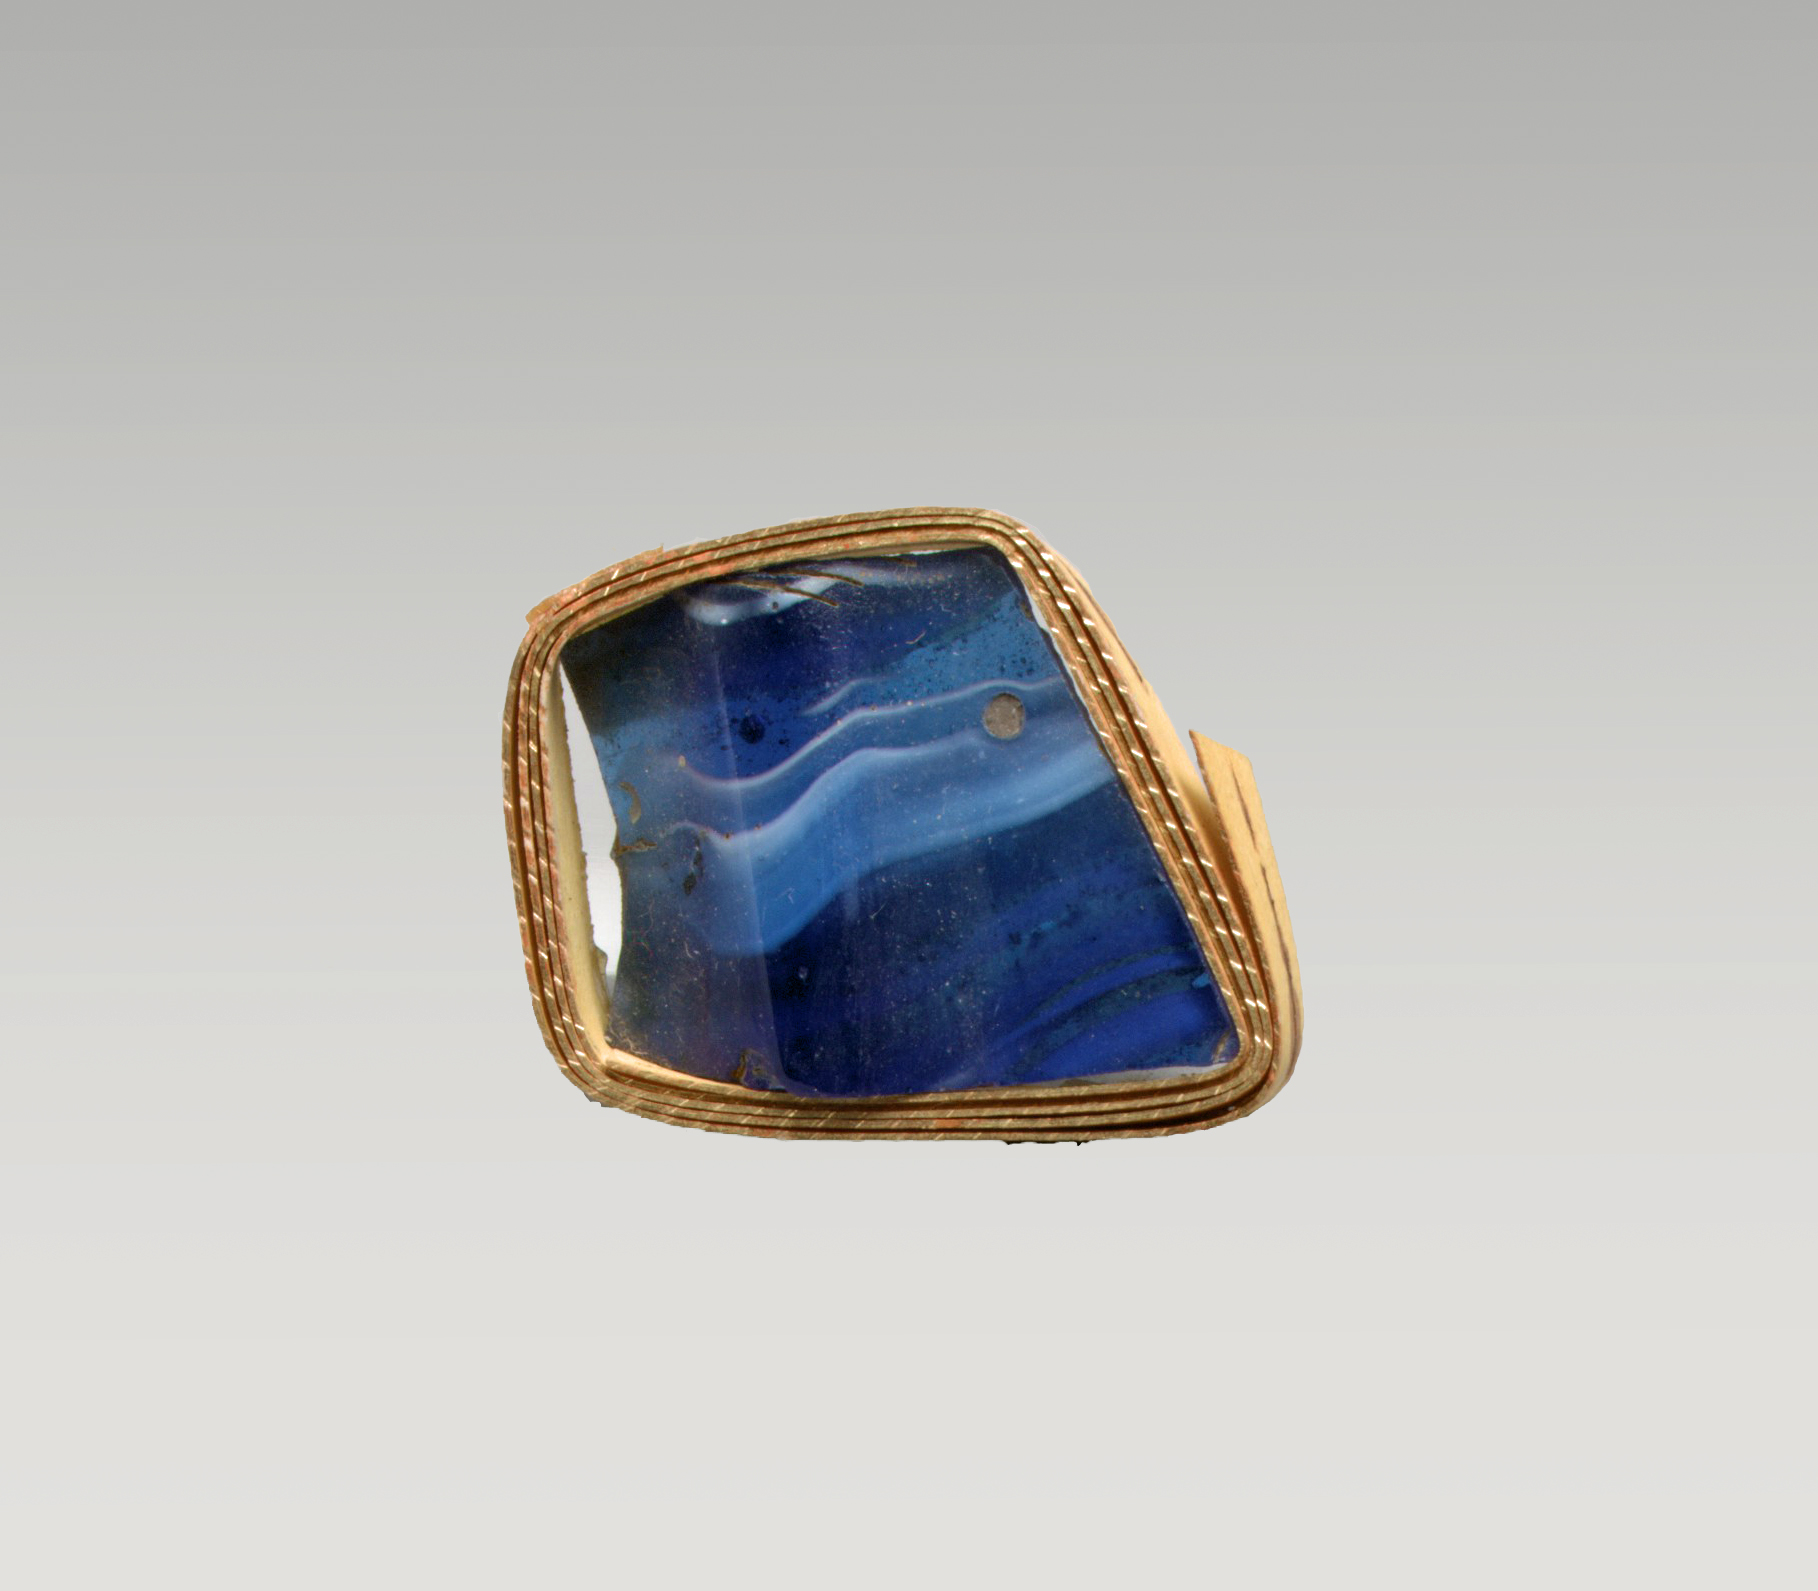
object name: fragment, mosaic bowl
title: Mosaic glass ribbed bowl fragment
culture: roman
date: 34 BCE-33 CE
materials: glass